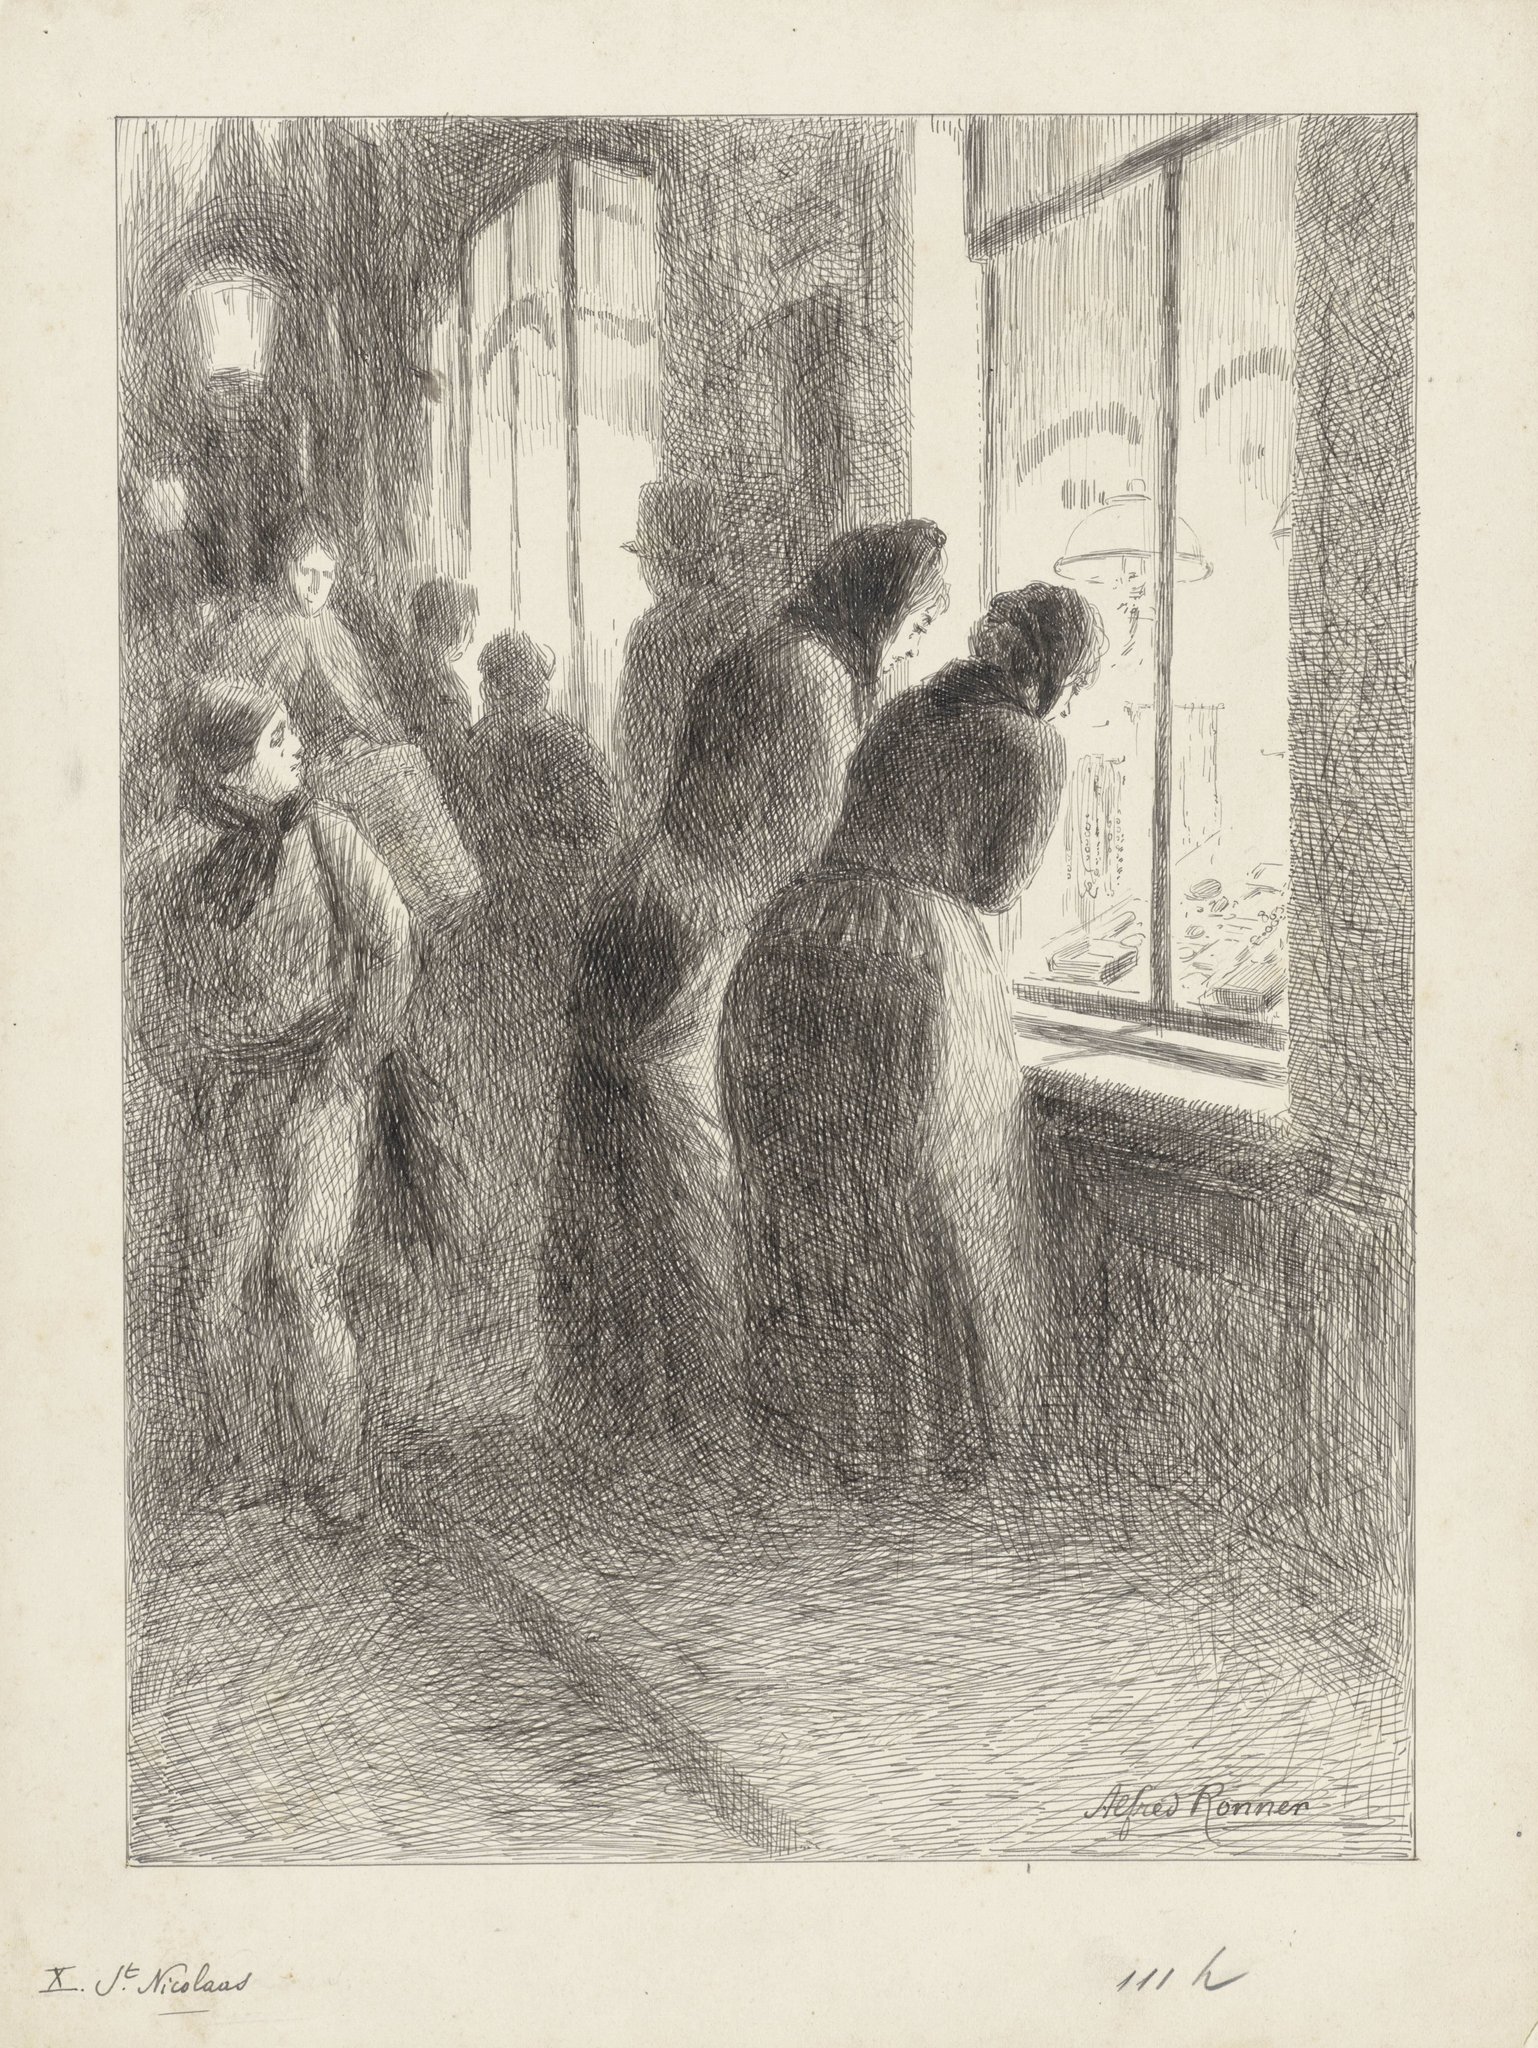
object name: design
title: St. Nicolaas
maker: alfred ronner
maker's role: draughtsman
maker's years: 1852-1901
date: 1893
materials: ink, paper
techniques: pen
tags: shop, store, (reiger, a.f.j., vluchtige schetsen uit het volksleven) specific works of literature (with author, title), festivities on st. nicholas (eve) (december 5), marketing, shopping (~ household management)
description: Illustratie voor 'Vluchtige Schetsen uit het Volksleven' door A.F.J. Reiger. Ontwerp voor een prent.